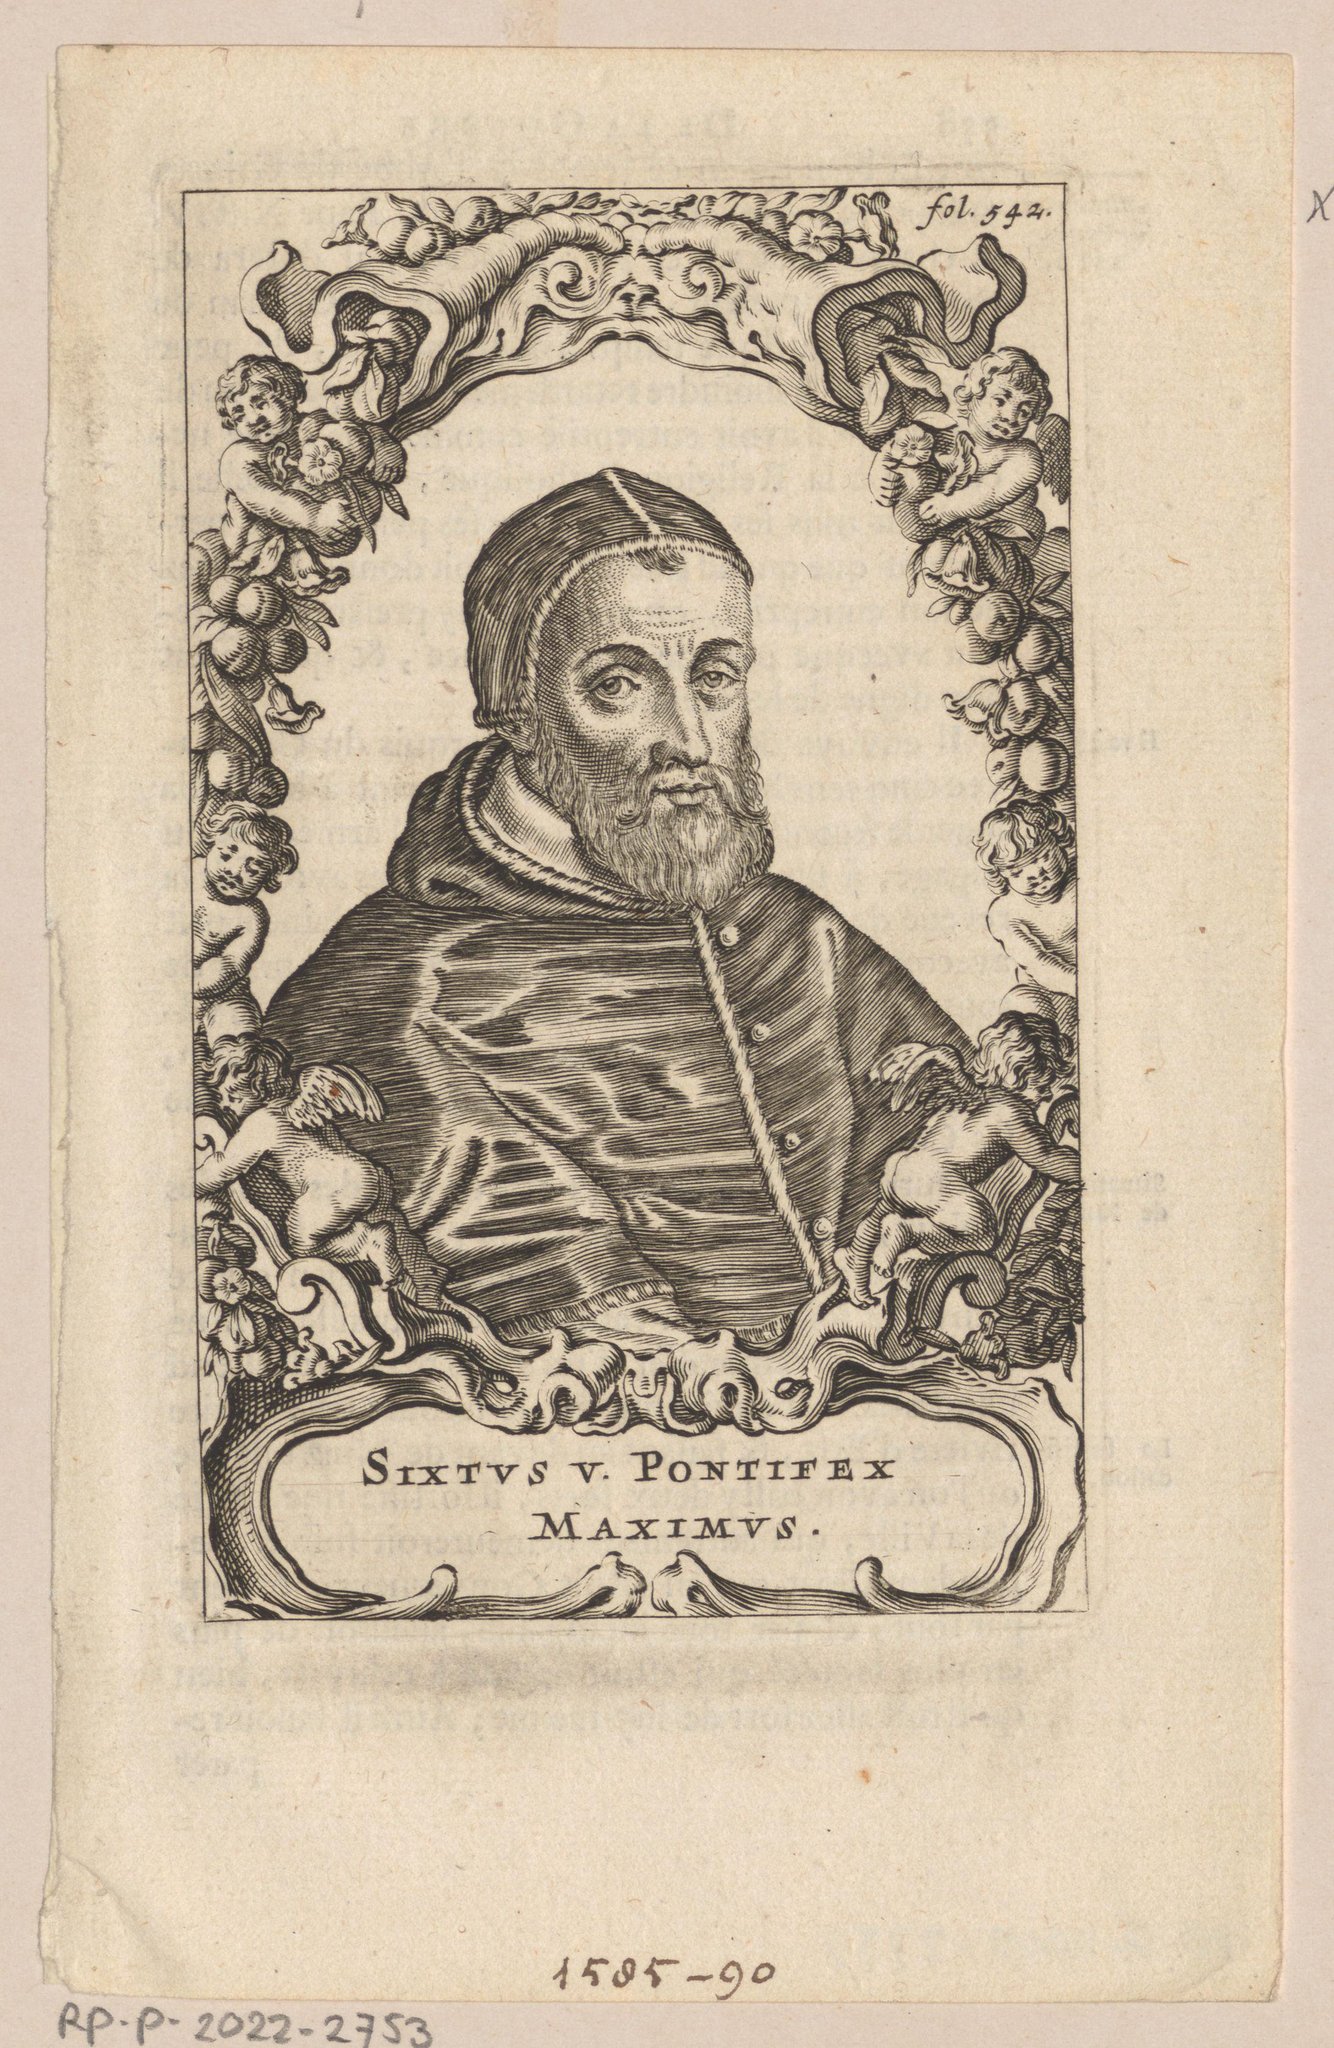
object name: print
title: Portret van Sixtus V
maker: Anonymous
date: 1665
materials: paper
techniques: engraving, letterpress printing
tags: sixtus v, historical persons, pope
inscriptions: inscription: ‘1585-90’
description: Prent uit: Strada, Famiano. Histoire de la guerre de Flandre ... seconde decade. Parijs: s.n., dl. 2, 1665.